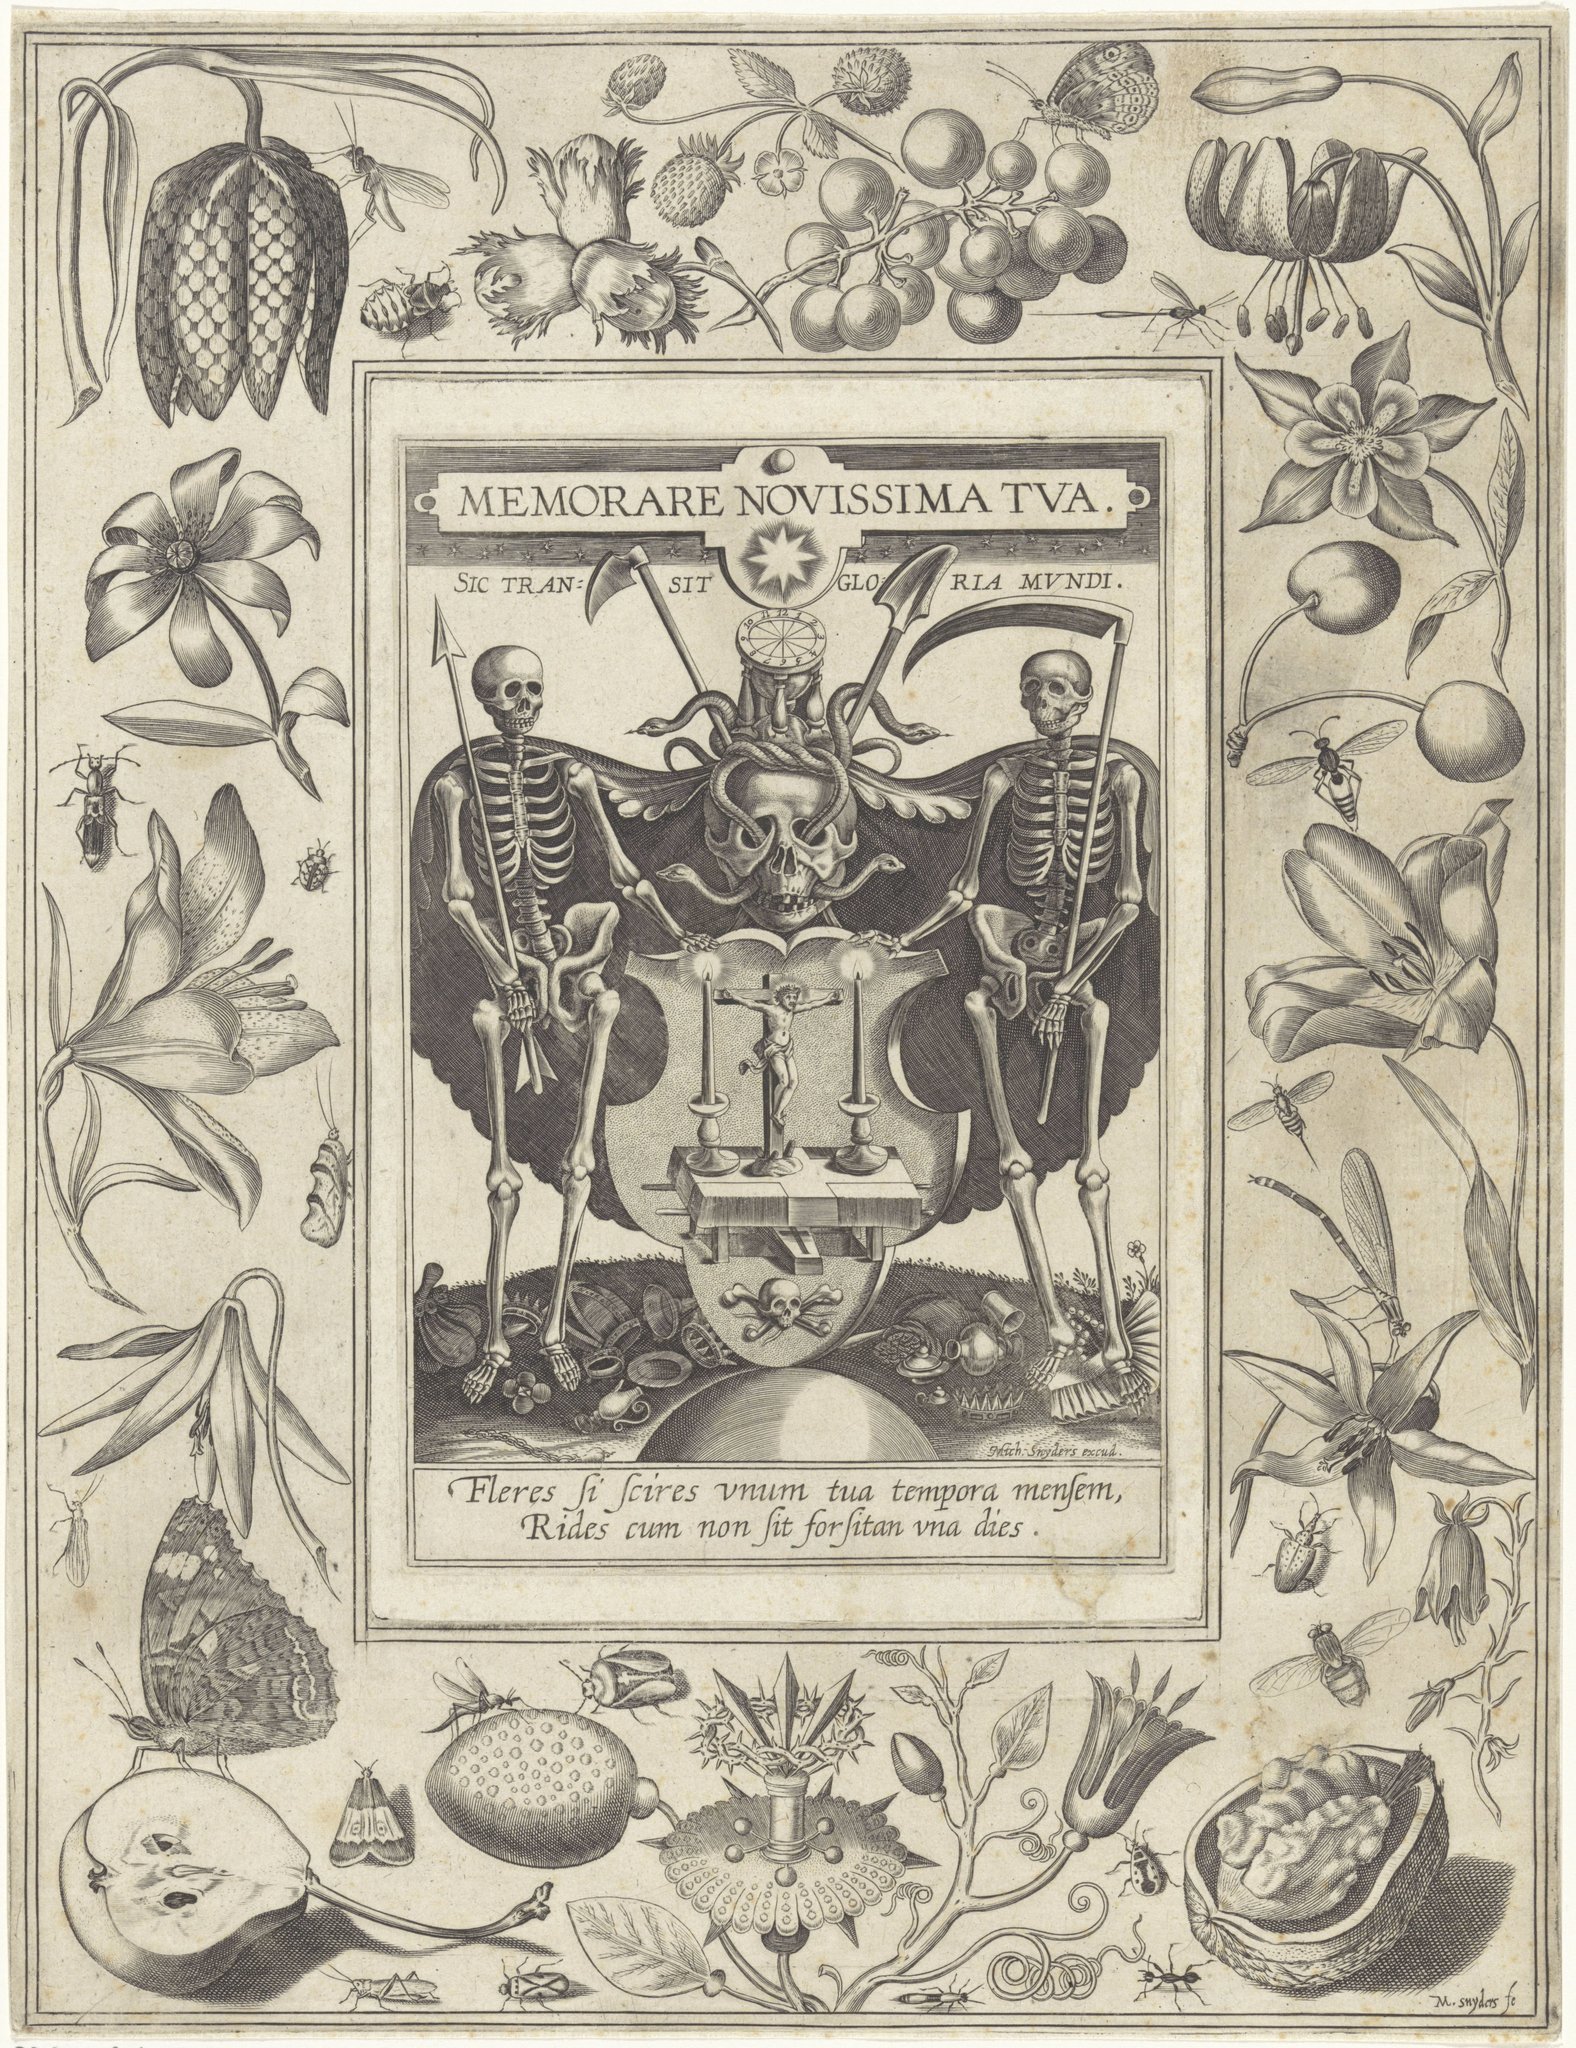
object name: print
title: Allegorie van de dood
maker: michael snijders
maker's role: print maker, publisher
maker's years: 1586-1672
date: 1610-1672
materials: paper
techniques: engraving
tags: flowers, protective weapons: shield, snakes, altarcross, crucifix, fruits: nuts, (human) skeleton, insects, fruits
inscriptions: collector's mark: Lugt 2228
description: Twee geraamtes met een mantel om de schouders houden een wapenschild op met daarop de afbeelding van een altaar met een crucifix en kaarsen. Tussen hen in een met een zonnewijzer gekroonde schedel waardoor slangen kronkelen. Op de grond liggen tekenen van wereldse weelde, waaronder een kroon, mijter en zak met geld. Onder en boven de prent zinspreuken in het Latijn betreffende de sterfelijkheid. Om de voorstelling heen een rand met noten, vruchten, bloemen en insecten naar Joris Hoefnagel, gedrukt vanaf een aparte plaat.